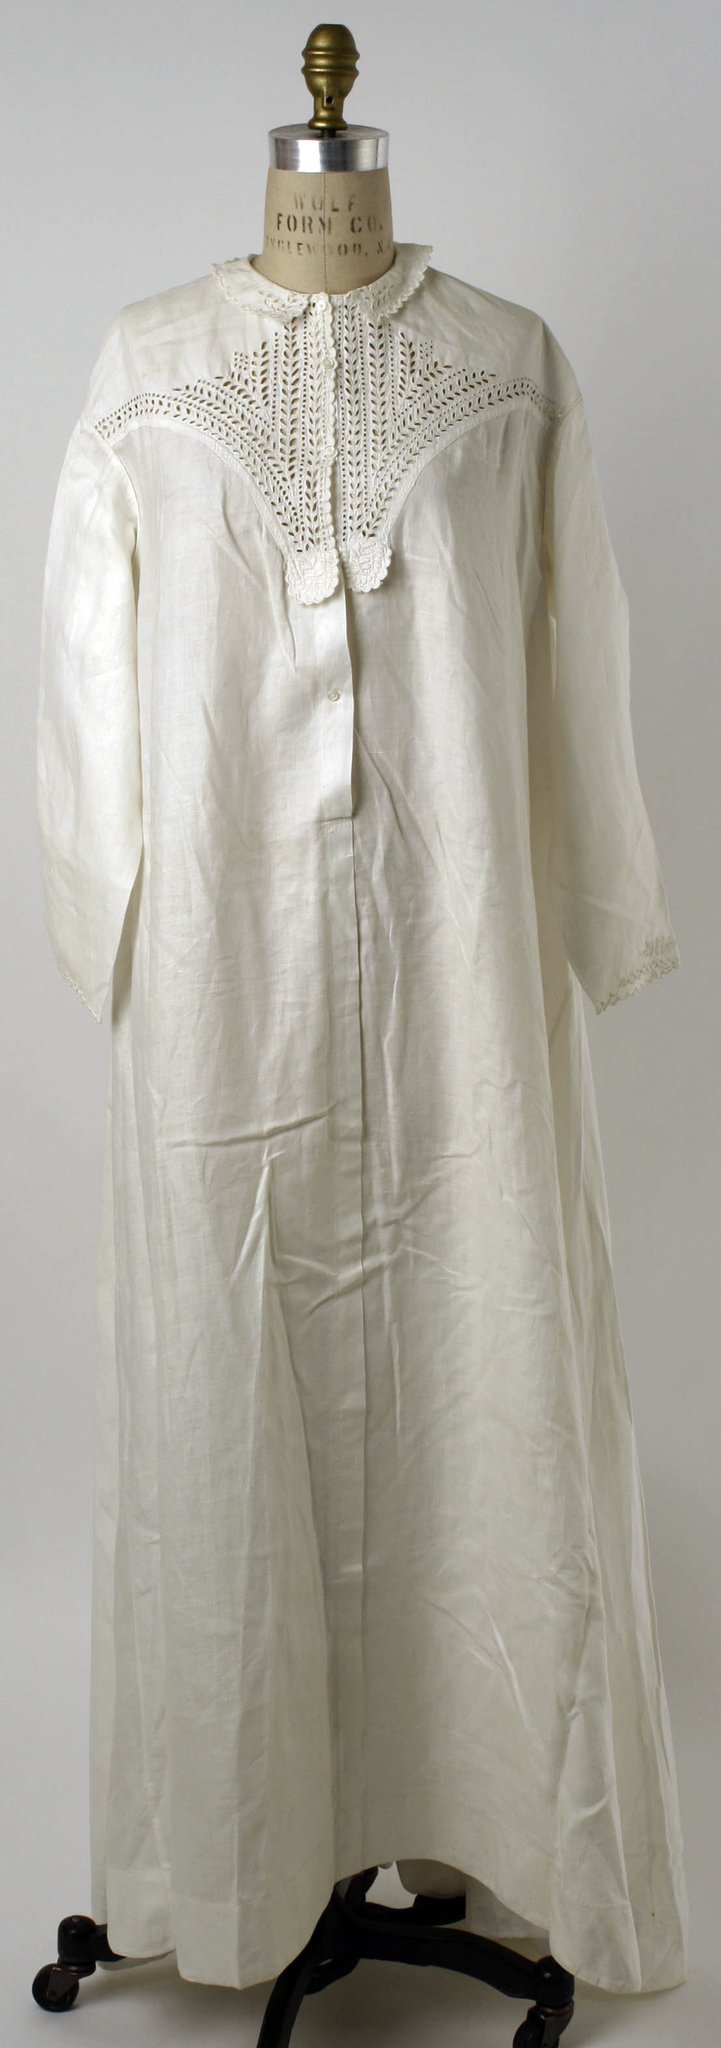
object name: nightgown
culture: american or european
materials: linen